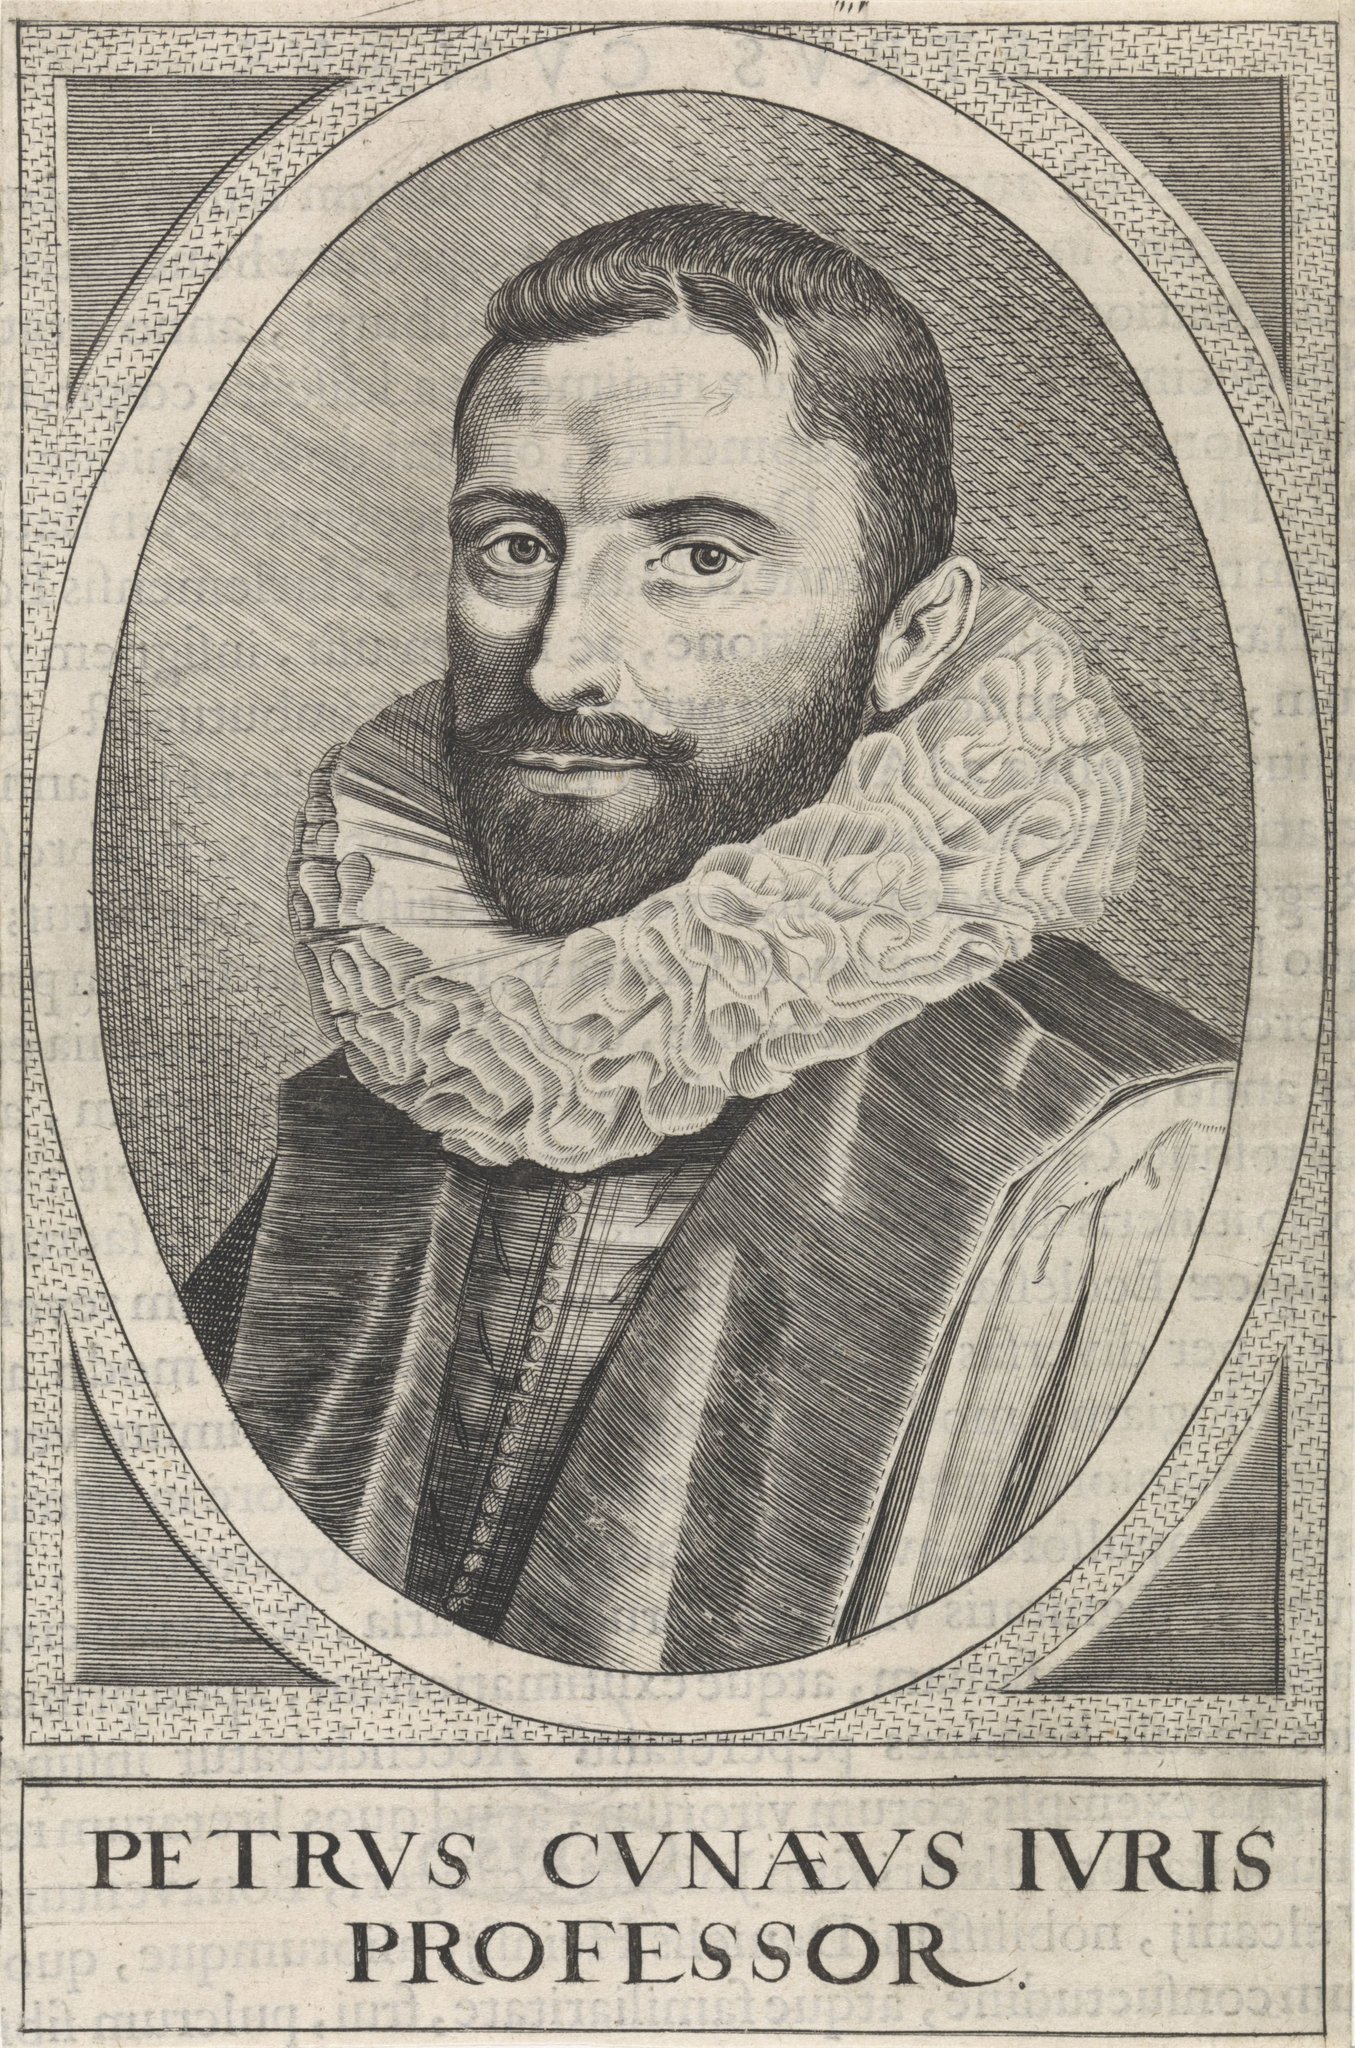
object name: print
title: Portret van Petrus Cunaeus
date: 1625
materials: paper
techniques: engraving, letterpress printing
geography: leiden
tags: flushing, leiden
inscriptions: collector's mark: Lugt 964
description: Boekillustratie in: Meursius, Joannes. Athenæ Batavæ. Sive, De vrbe Leidensi, & academiâ, virisque claris. Leiden: Andries Clouck, Bonaventura en Abraham Elzevier, 1625. Abusievelijk tweemaal gecatalogiseerd bij Franken & Van der Kellen.